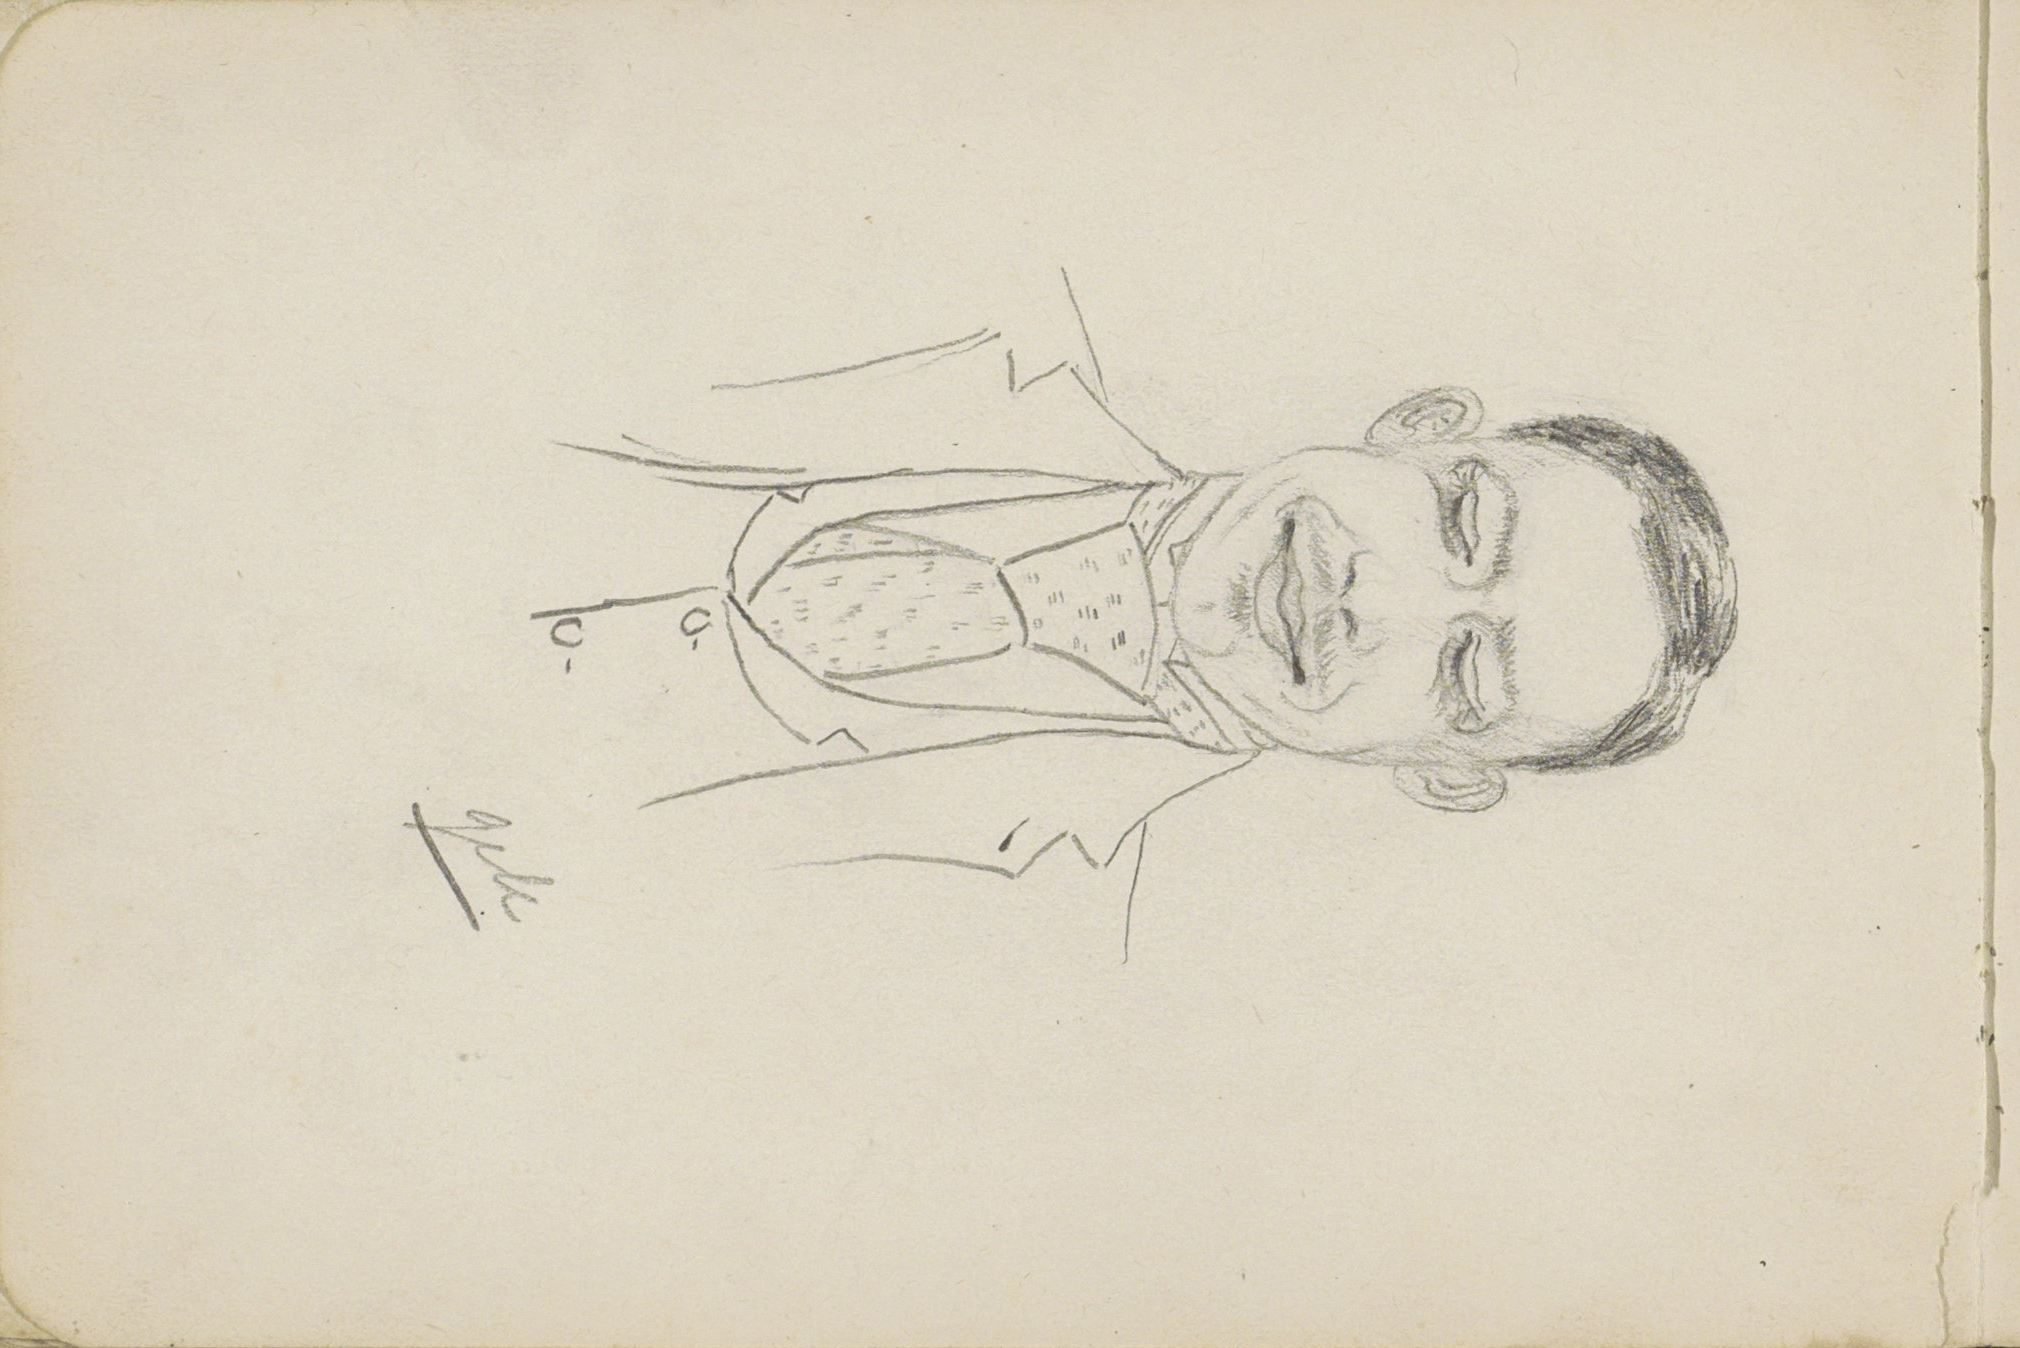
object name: sketchbook leaf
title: Man met bolle wangen in een pak met een stropdas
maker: julie de graag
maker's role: draughtsman, print maker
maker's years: 1877-1924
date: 1894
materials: paper, pencil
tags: head (human), adult man, smiling, eyes closed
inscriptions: annotation: ‘gek’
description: De man glimlacht en heeft de ogen gesloten. Blad 29 verso uit een schetsboek met 35 bladen.